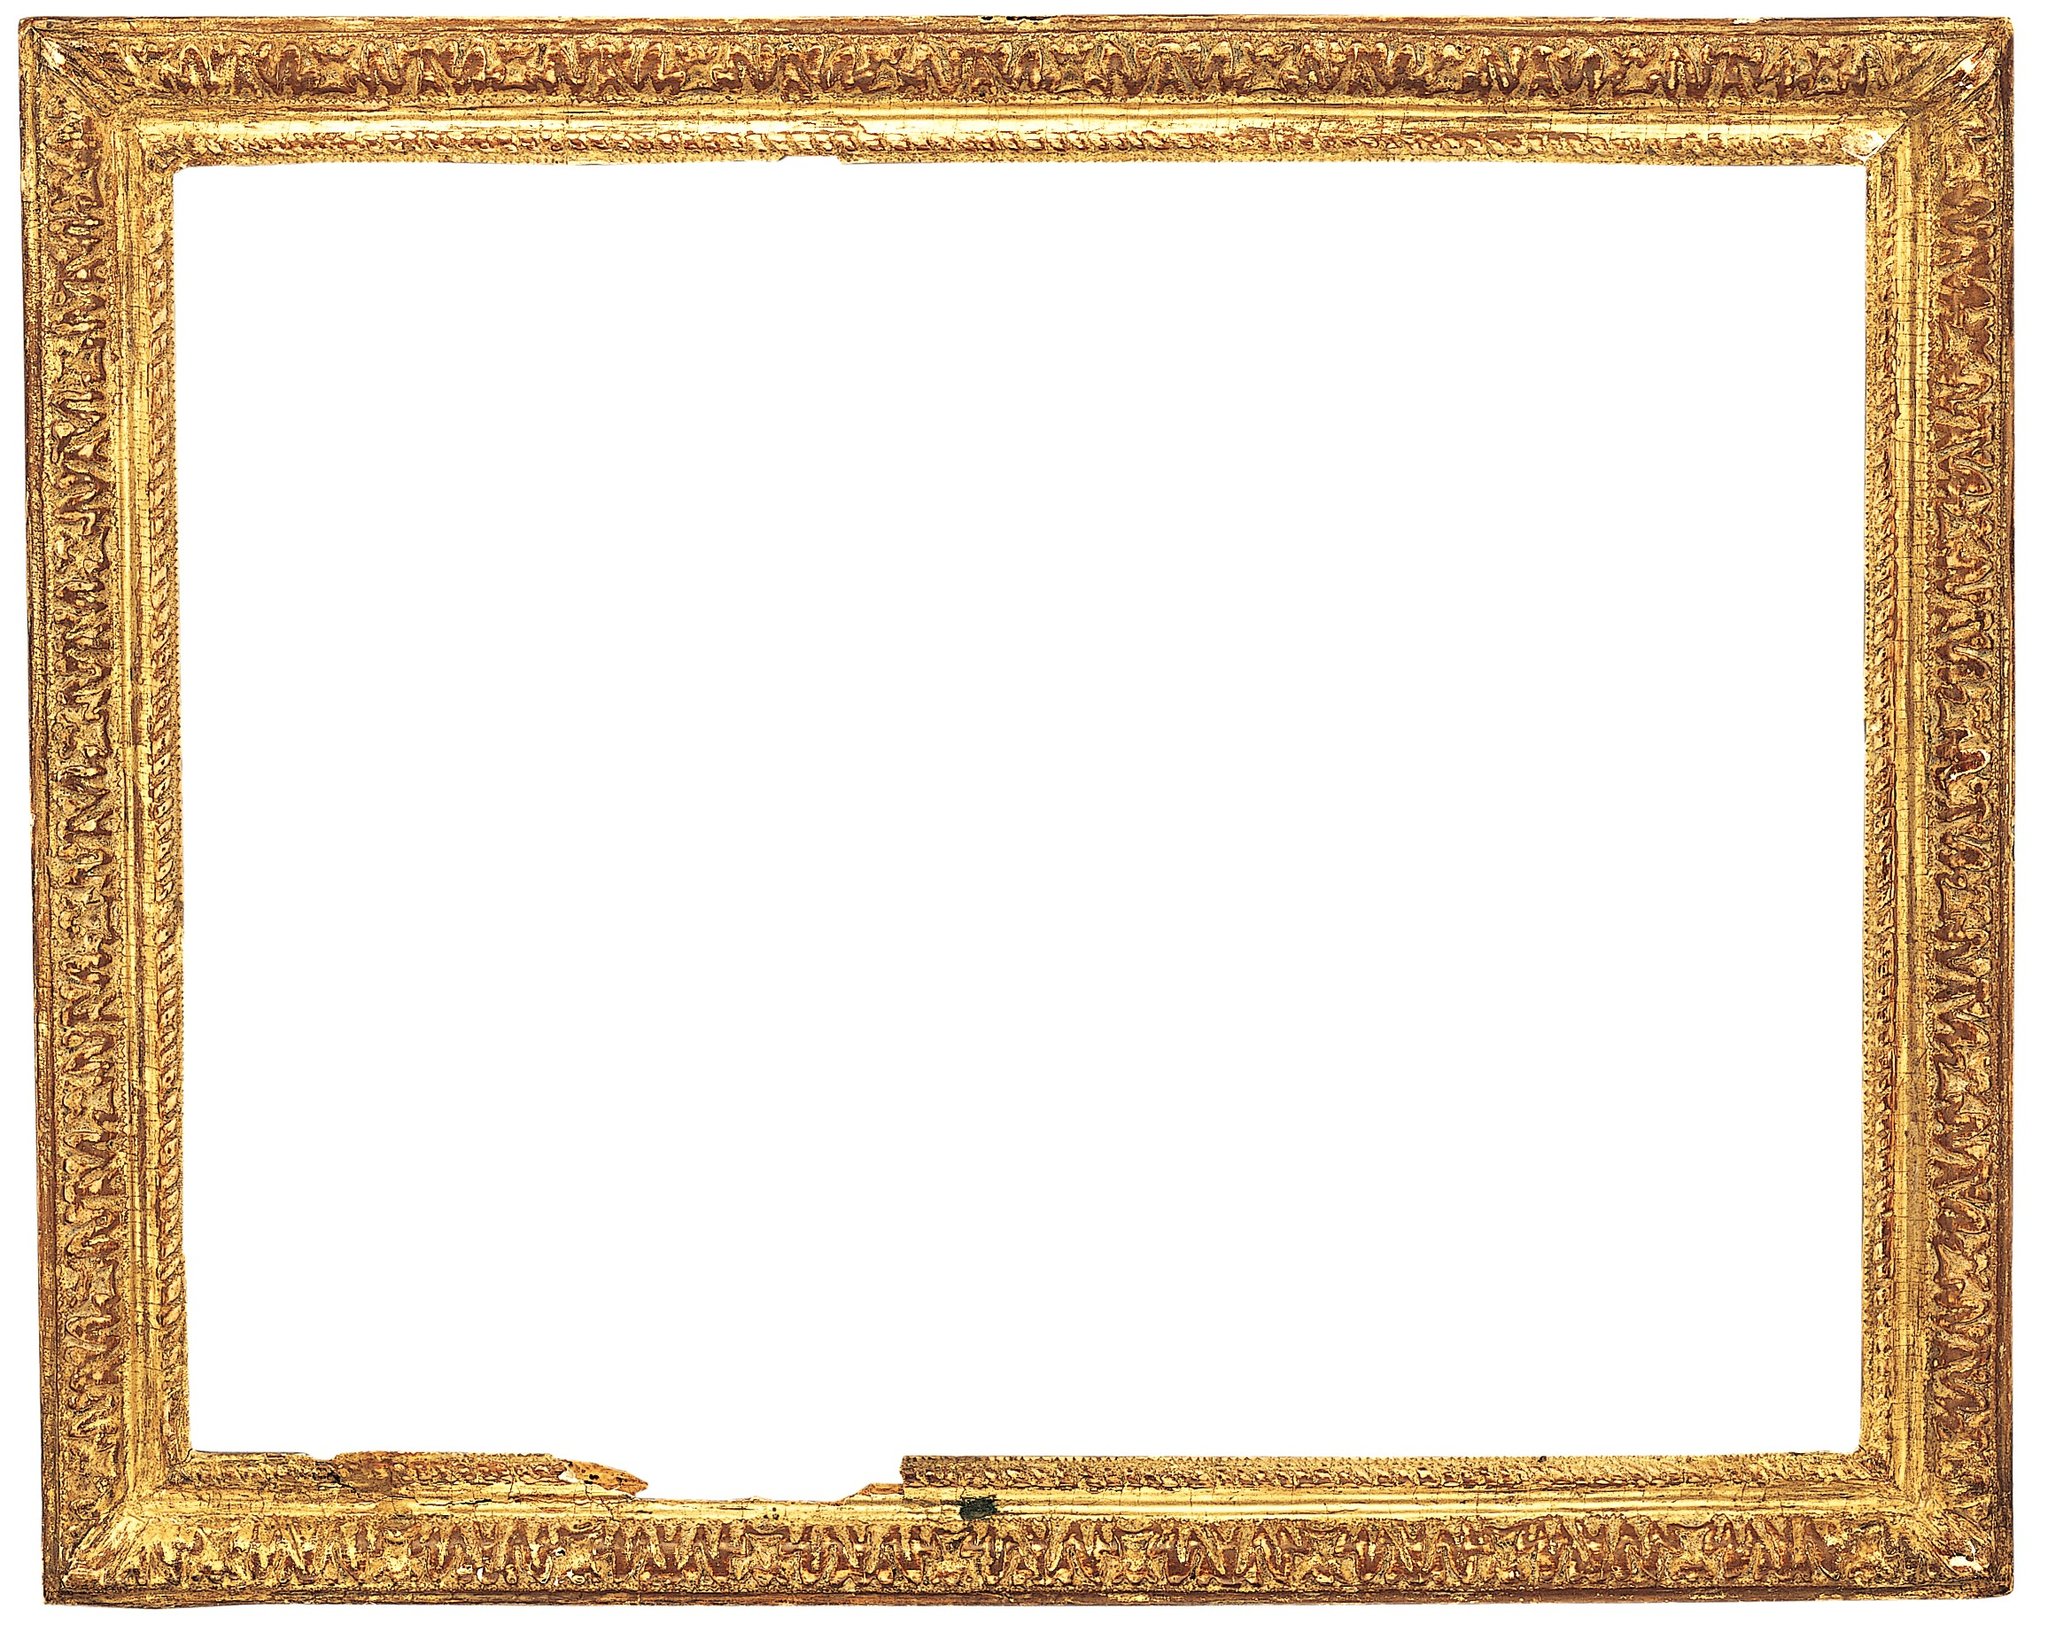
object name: frame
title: Astragal frame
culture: french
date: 1650-1660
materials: wood